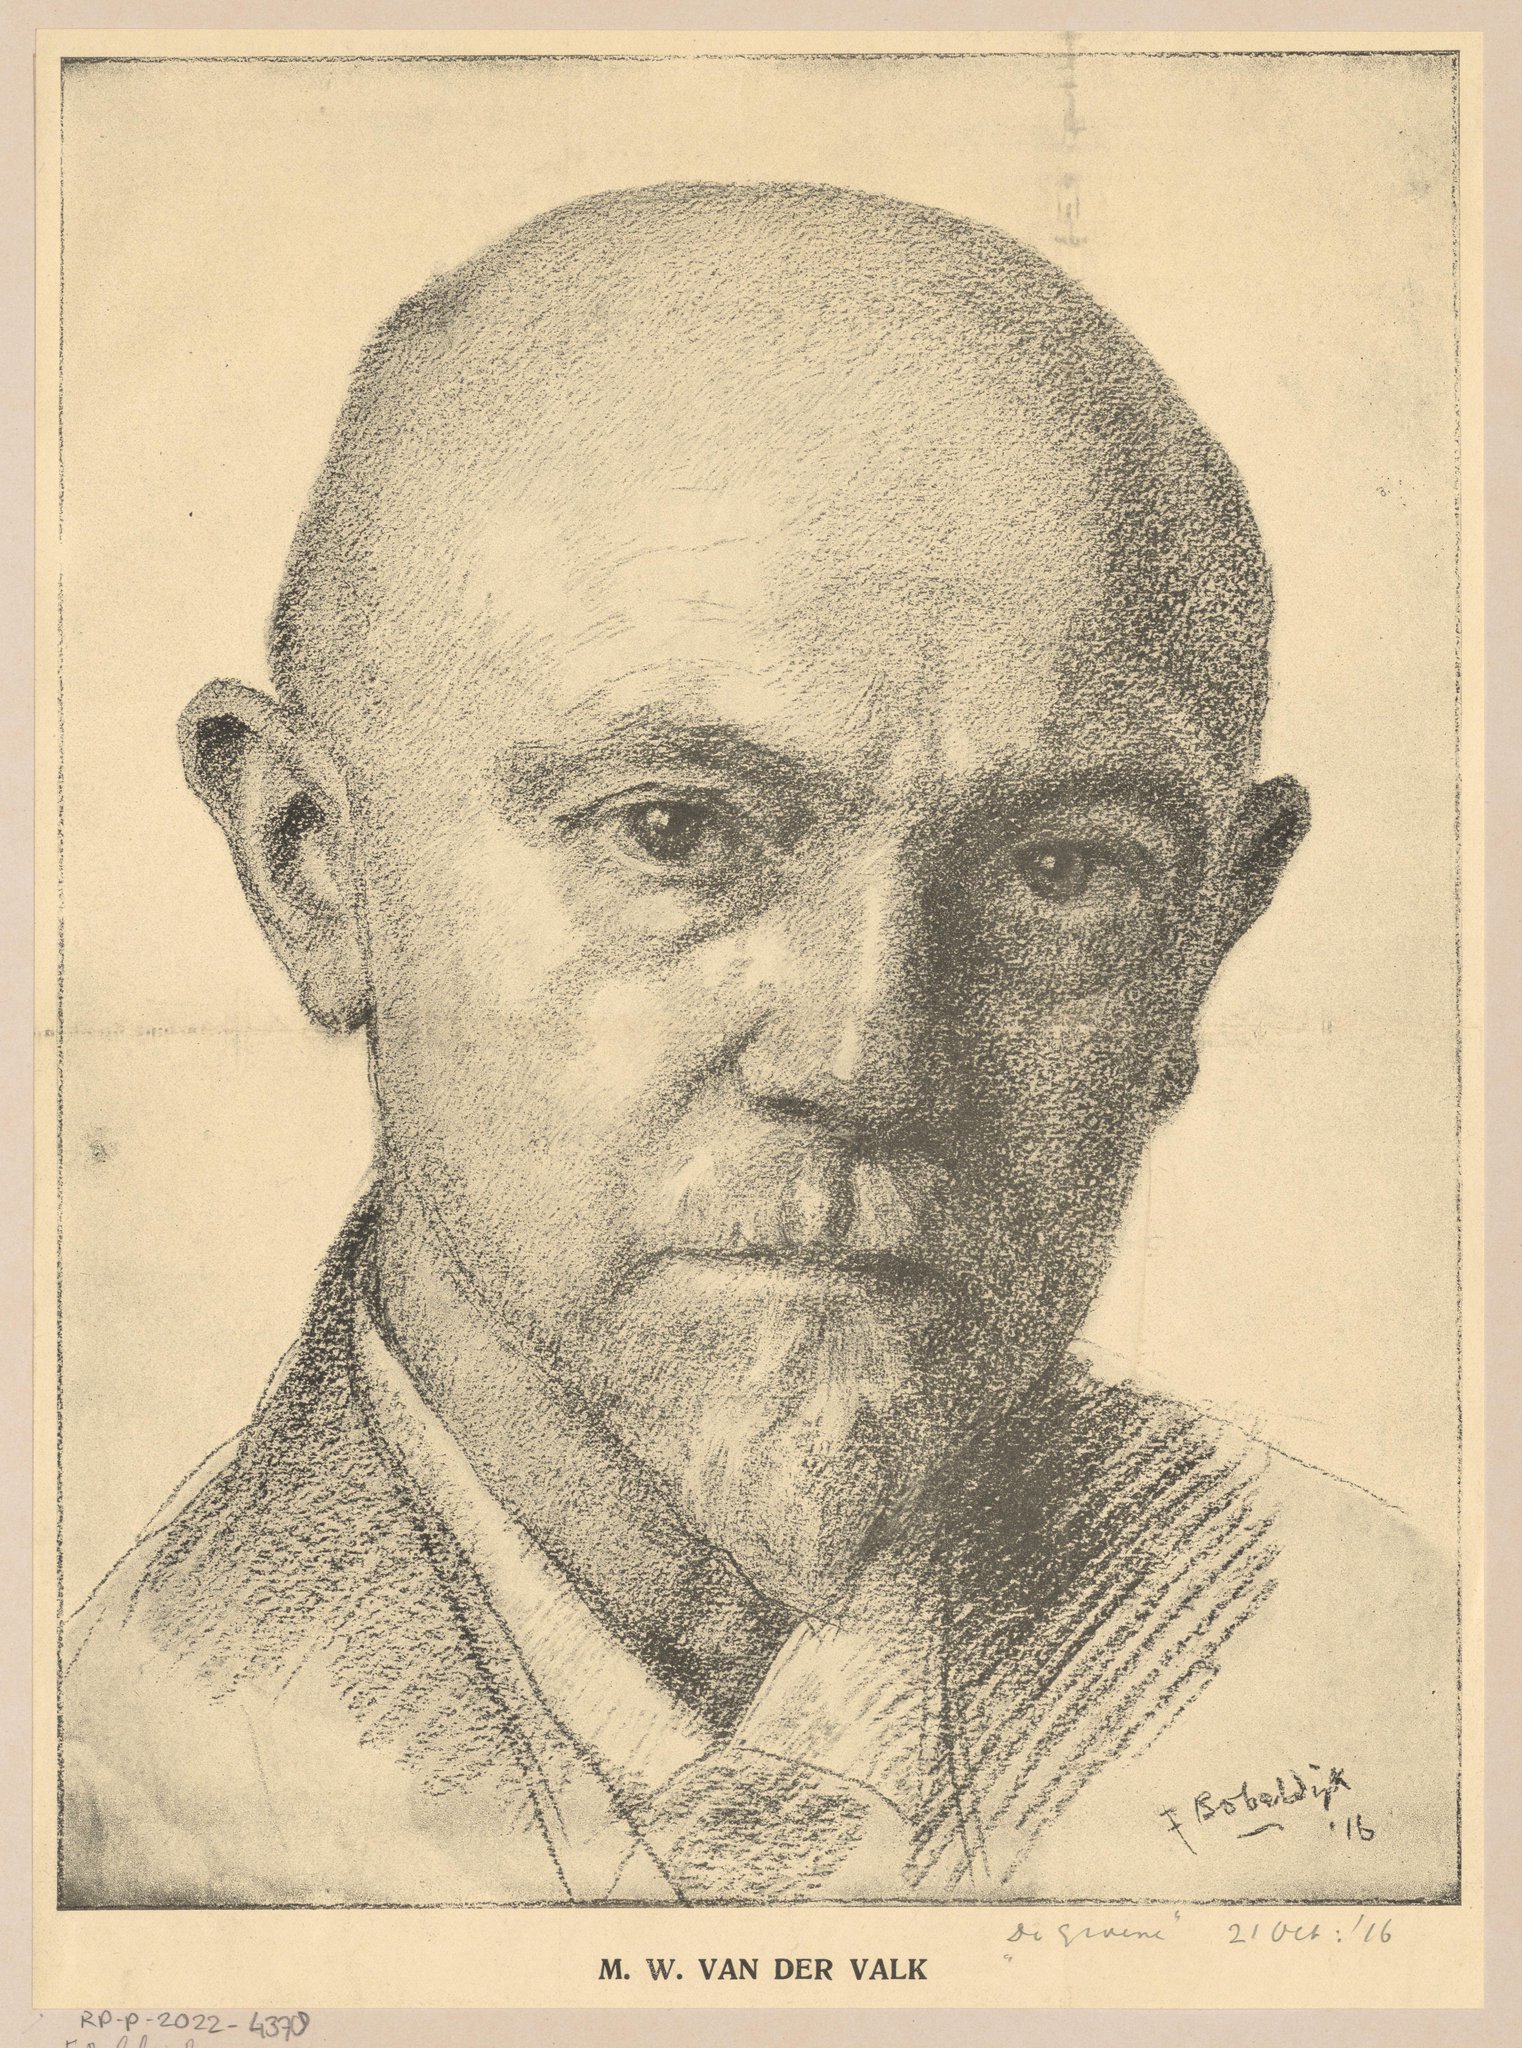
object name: photomechanical print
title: Portret van Maurits van der Valk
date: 1916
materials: paper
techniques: printing block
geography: amsterdam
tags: amsterdam, print maker, draughtsman, maurits van der valk, historical persons, portrait, self-portrait of graphic artist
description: Prent uit: De Amsterdammer, 21 oktober 1916.